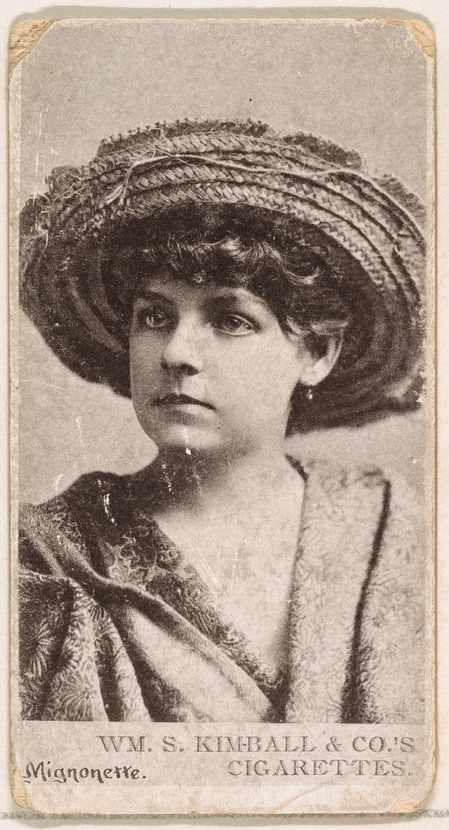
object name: print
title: Miss Mignonette, from the Actresses series (N190) issued by Wm. S. Kimball & Co.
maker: william s. kimball & company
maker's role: publisher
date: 1889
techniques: lithography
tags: portraits,women,actresses